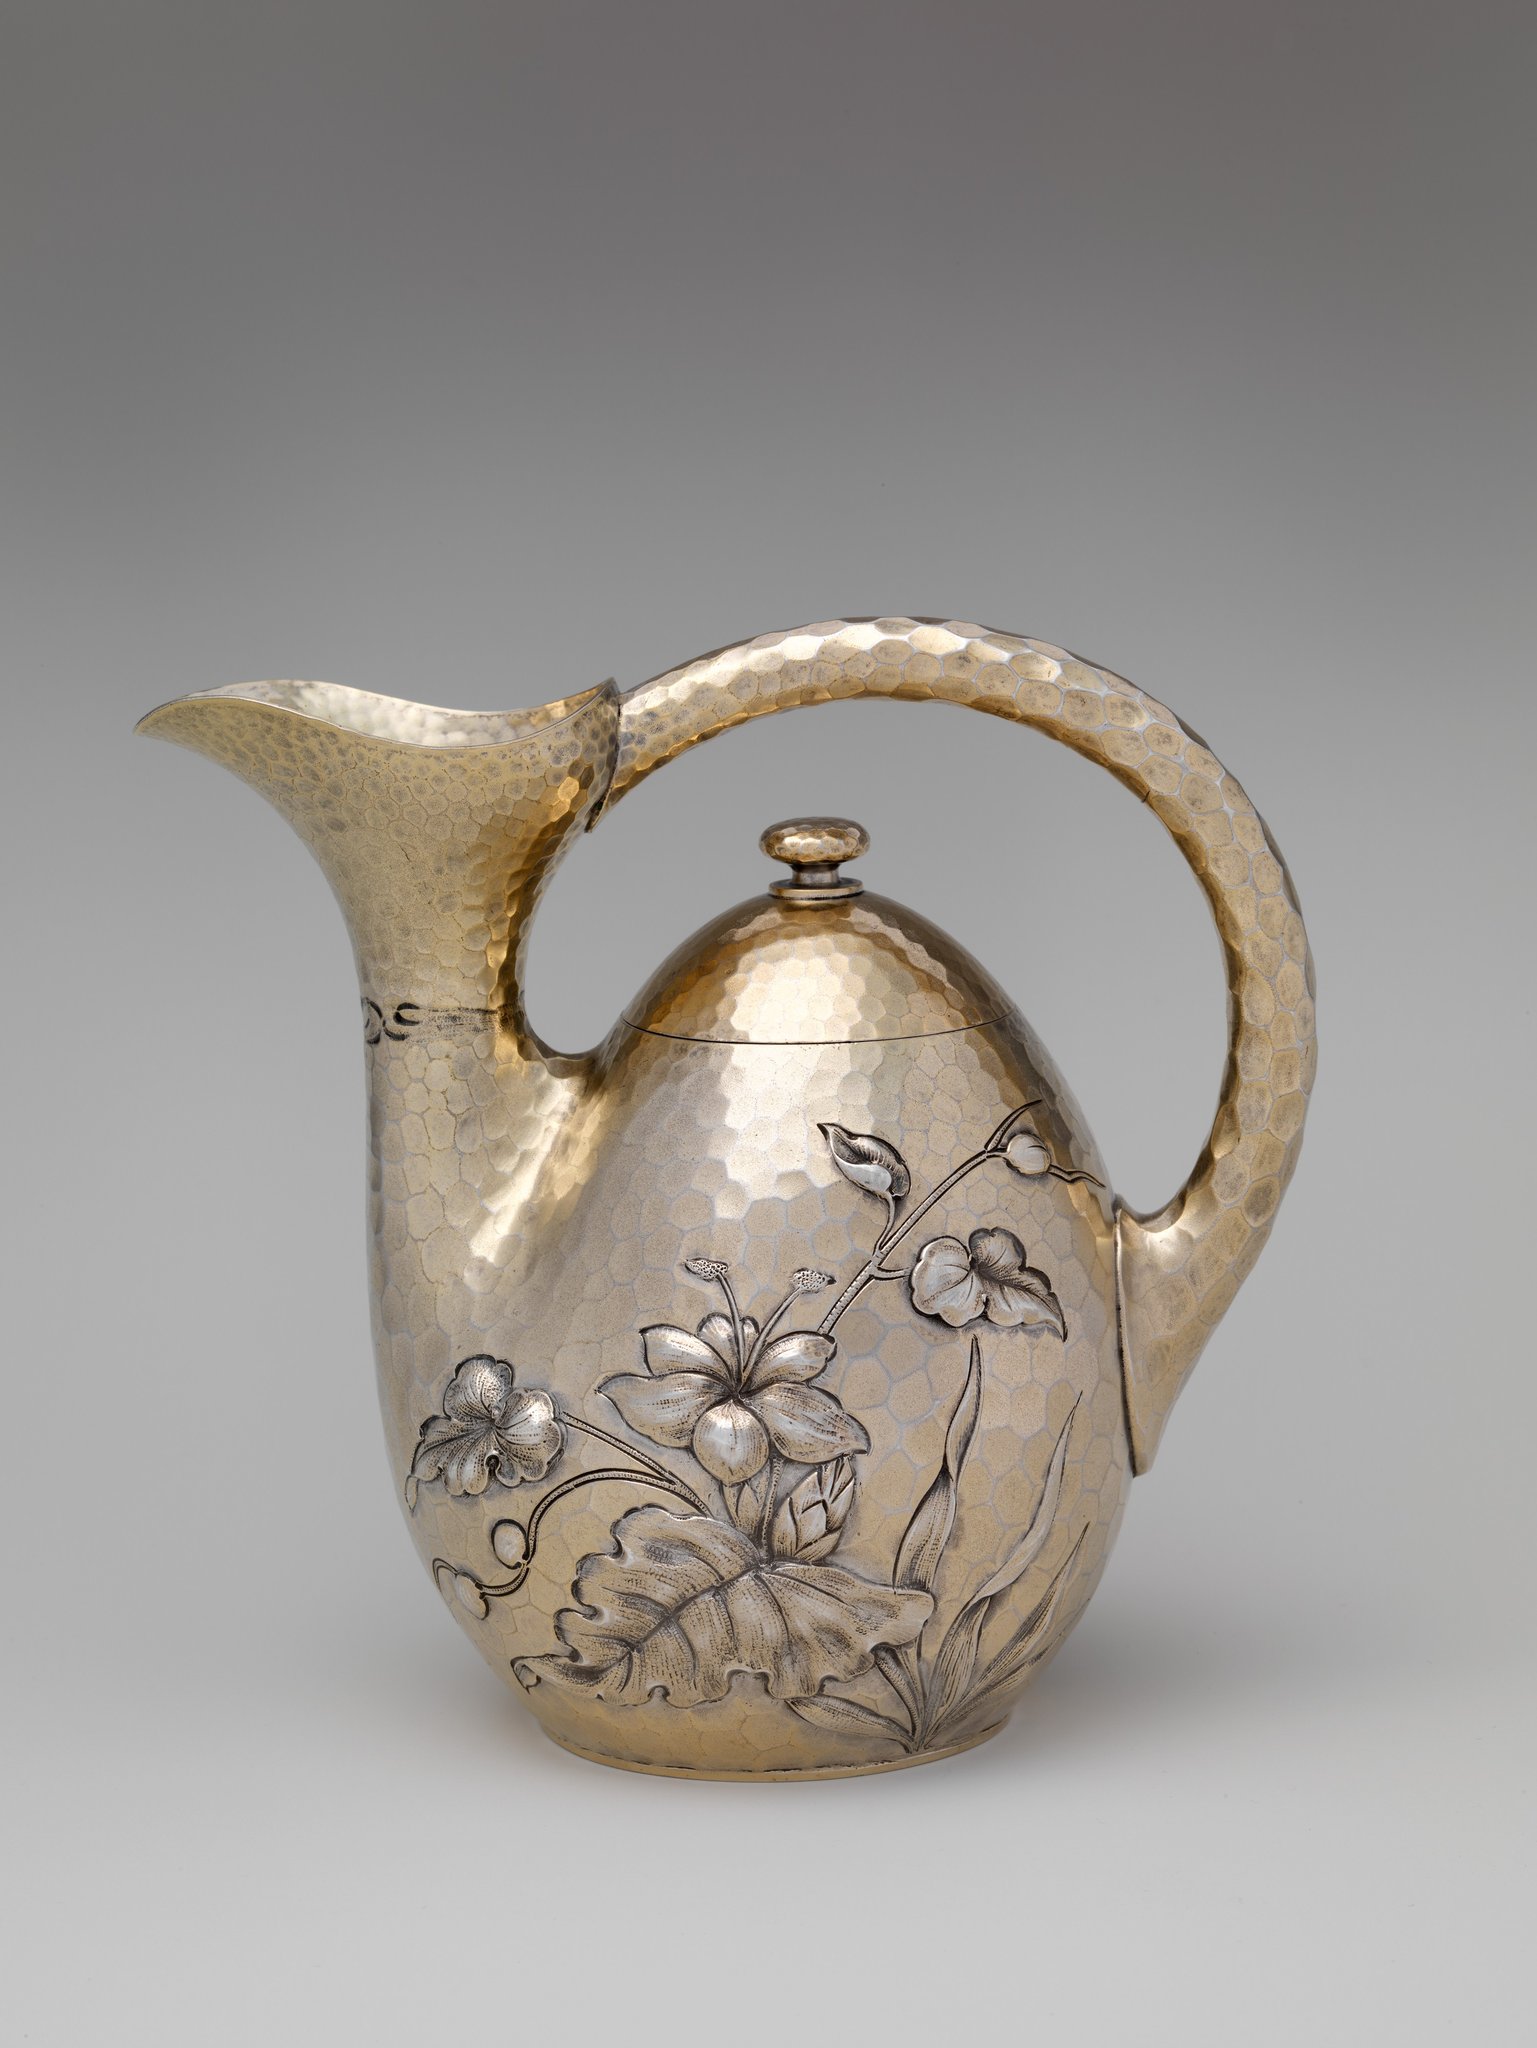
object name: wine pot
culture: american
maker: dominick & haff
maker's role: maker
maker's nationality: american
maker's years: 1872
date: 1882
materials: silver, silver gilt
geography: united states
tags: flowers